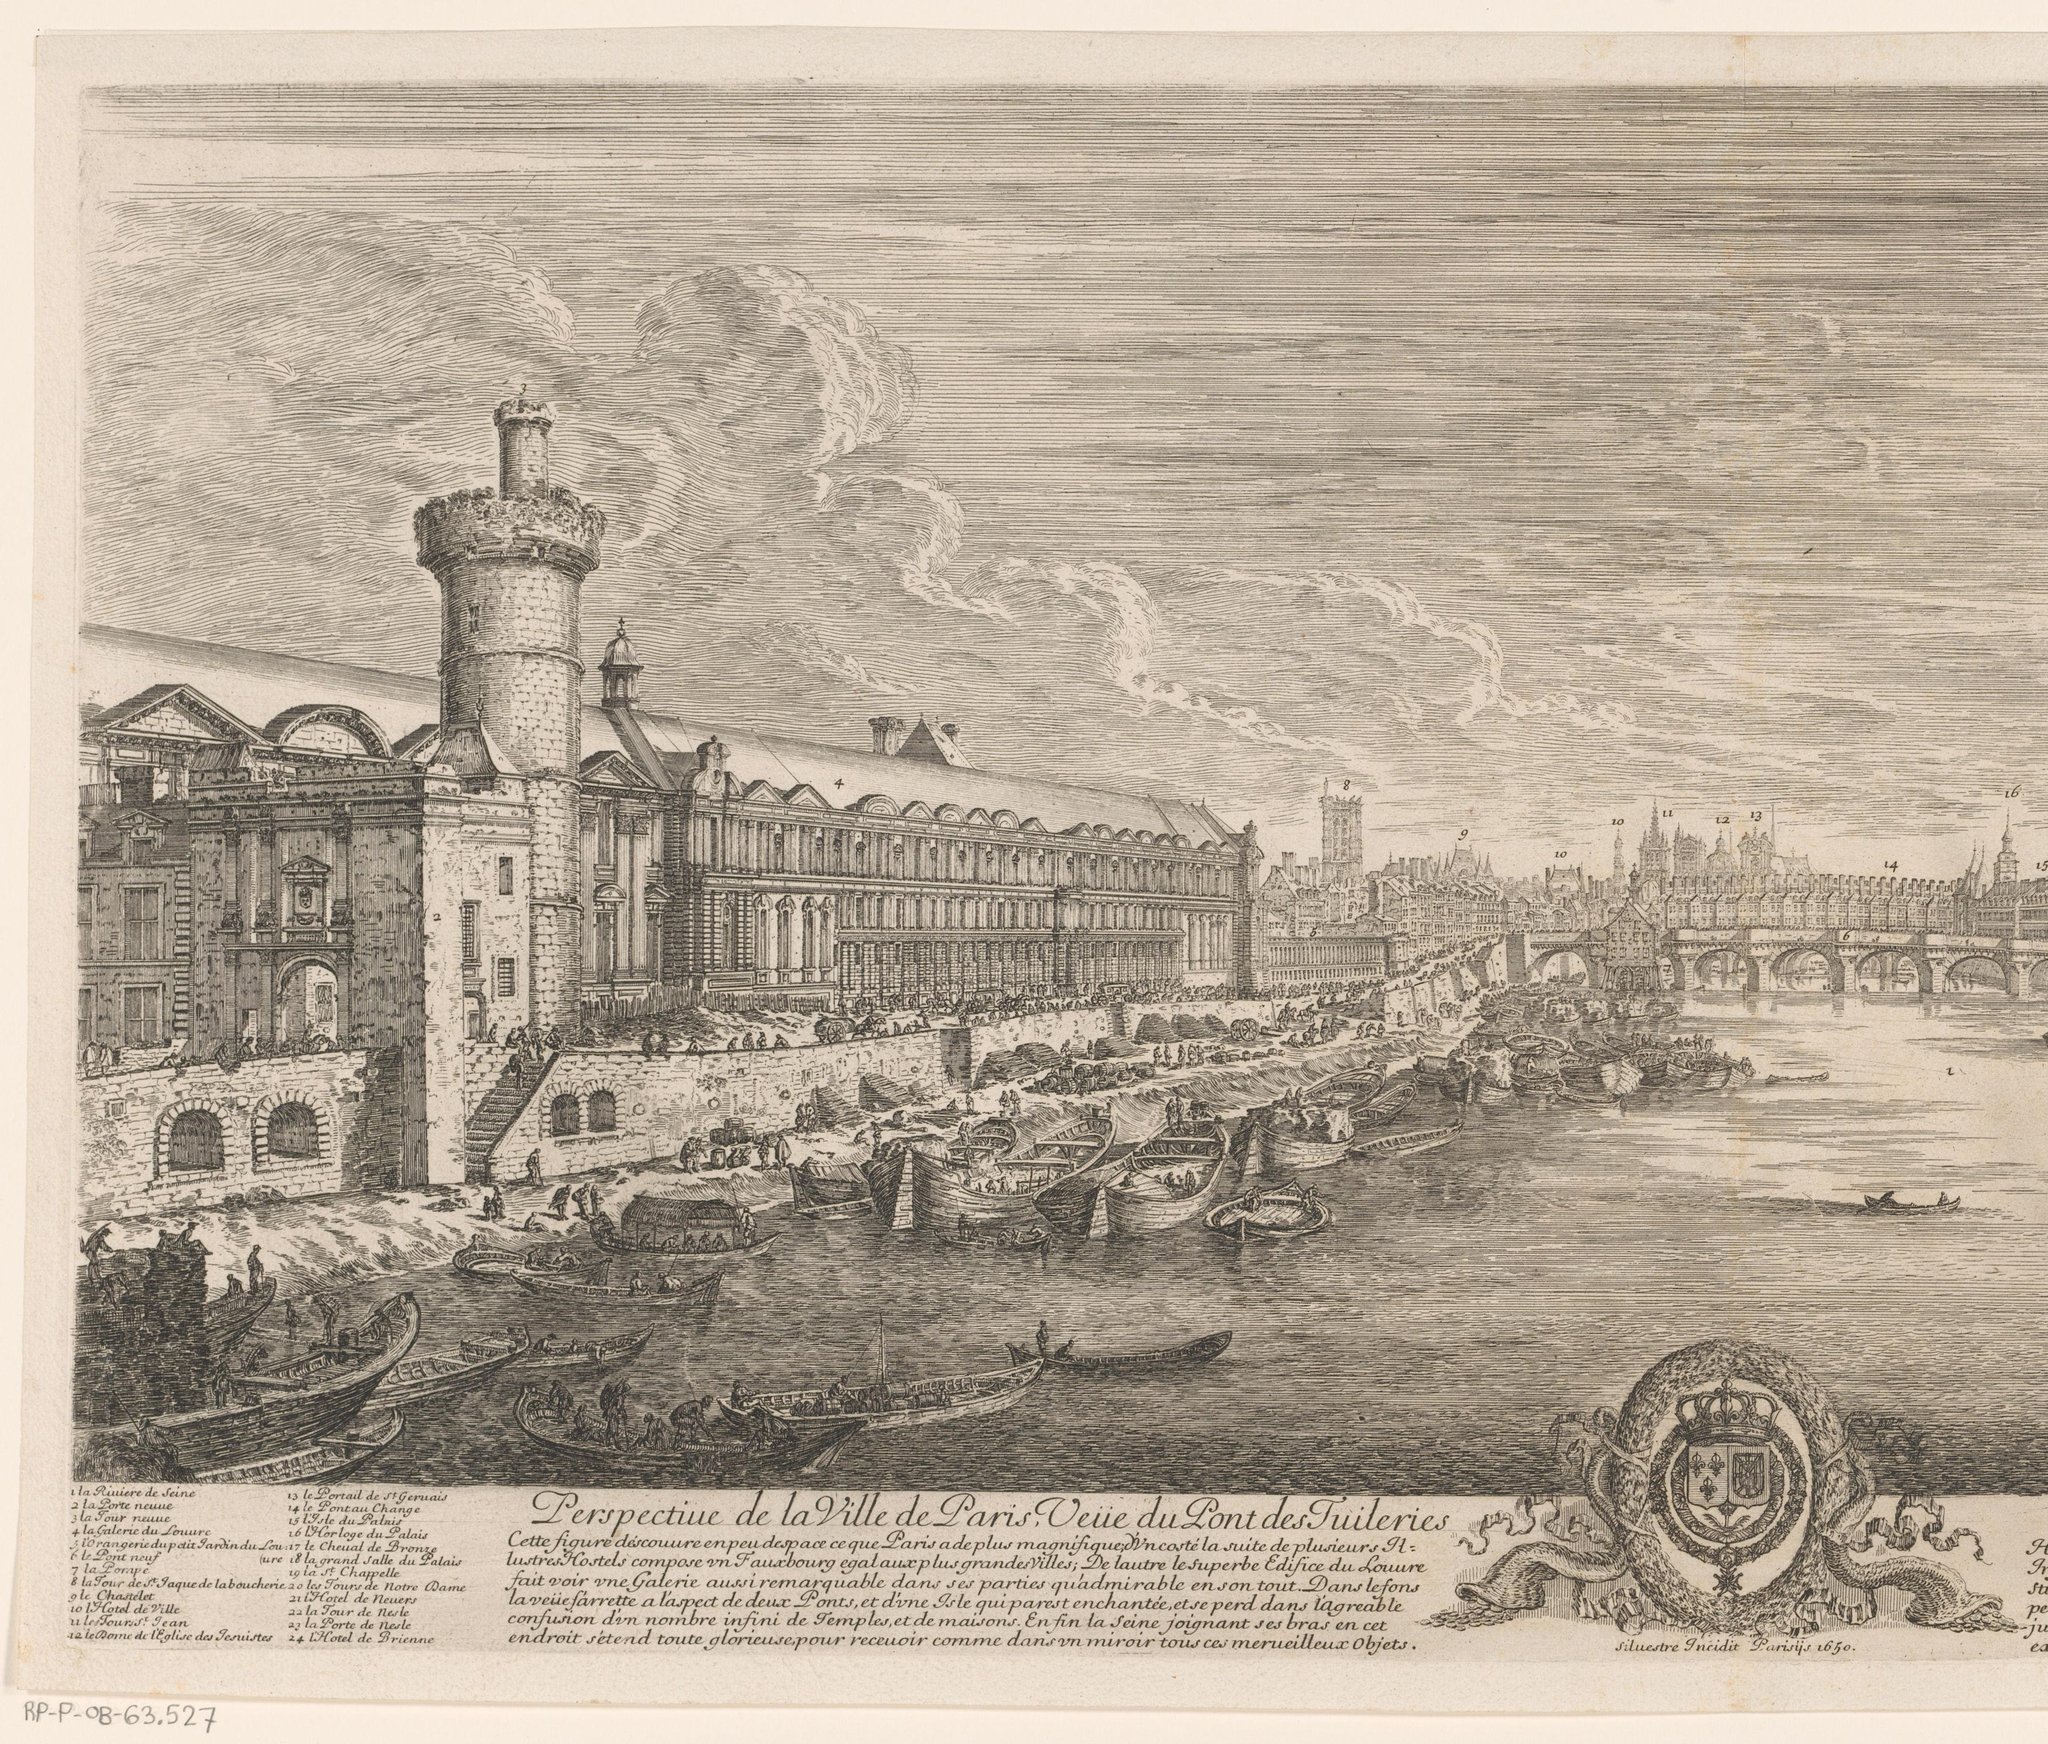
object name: print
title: Gezicht op Parijs vanaf de Pont des Tuileries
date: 1650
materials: paper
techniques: etching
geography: paris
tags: bridge in city across river, canal, etc., paris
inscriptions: collector's mark: Lugt 240